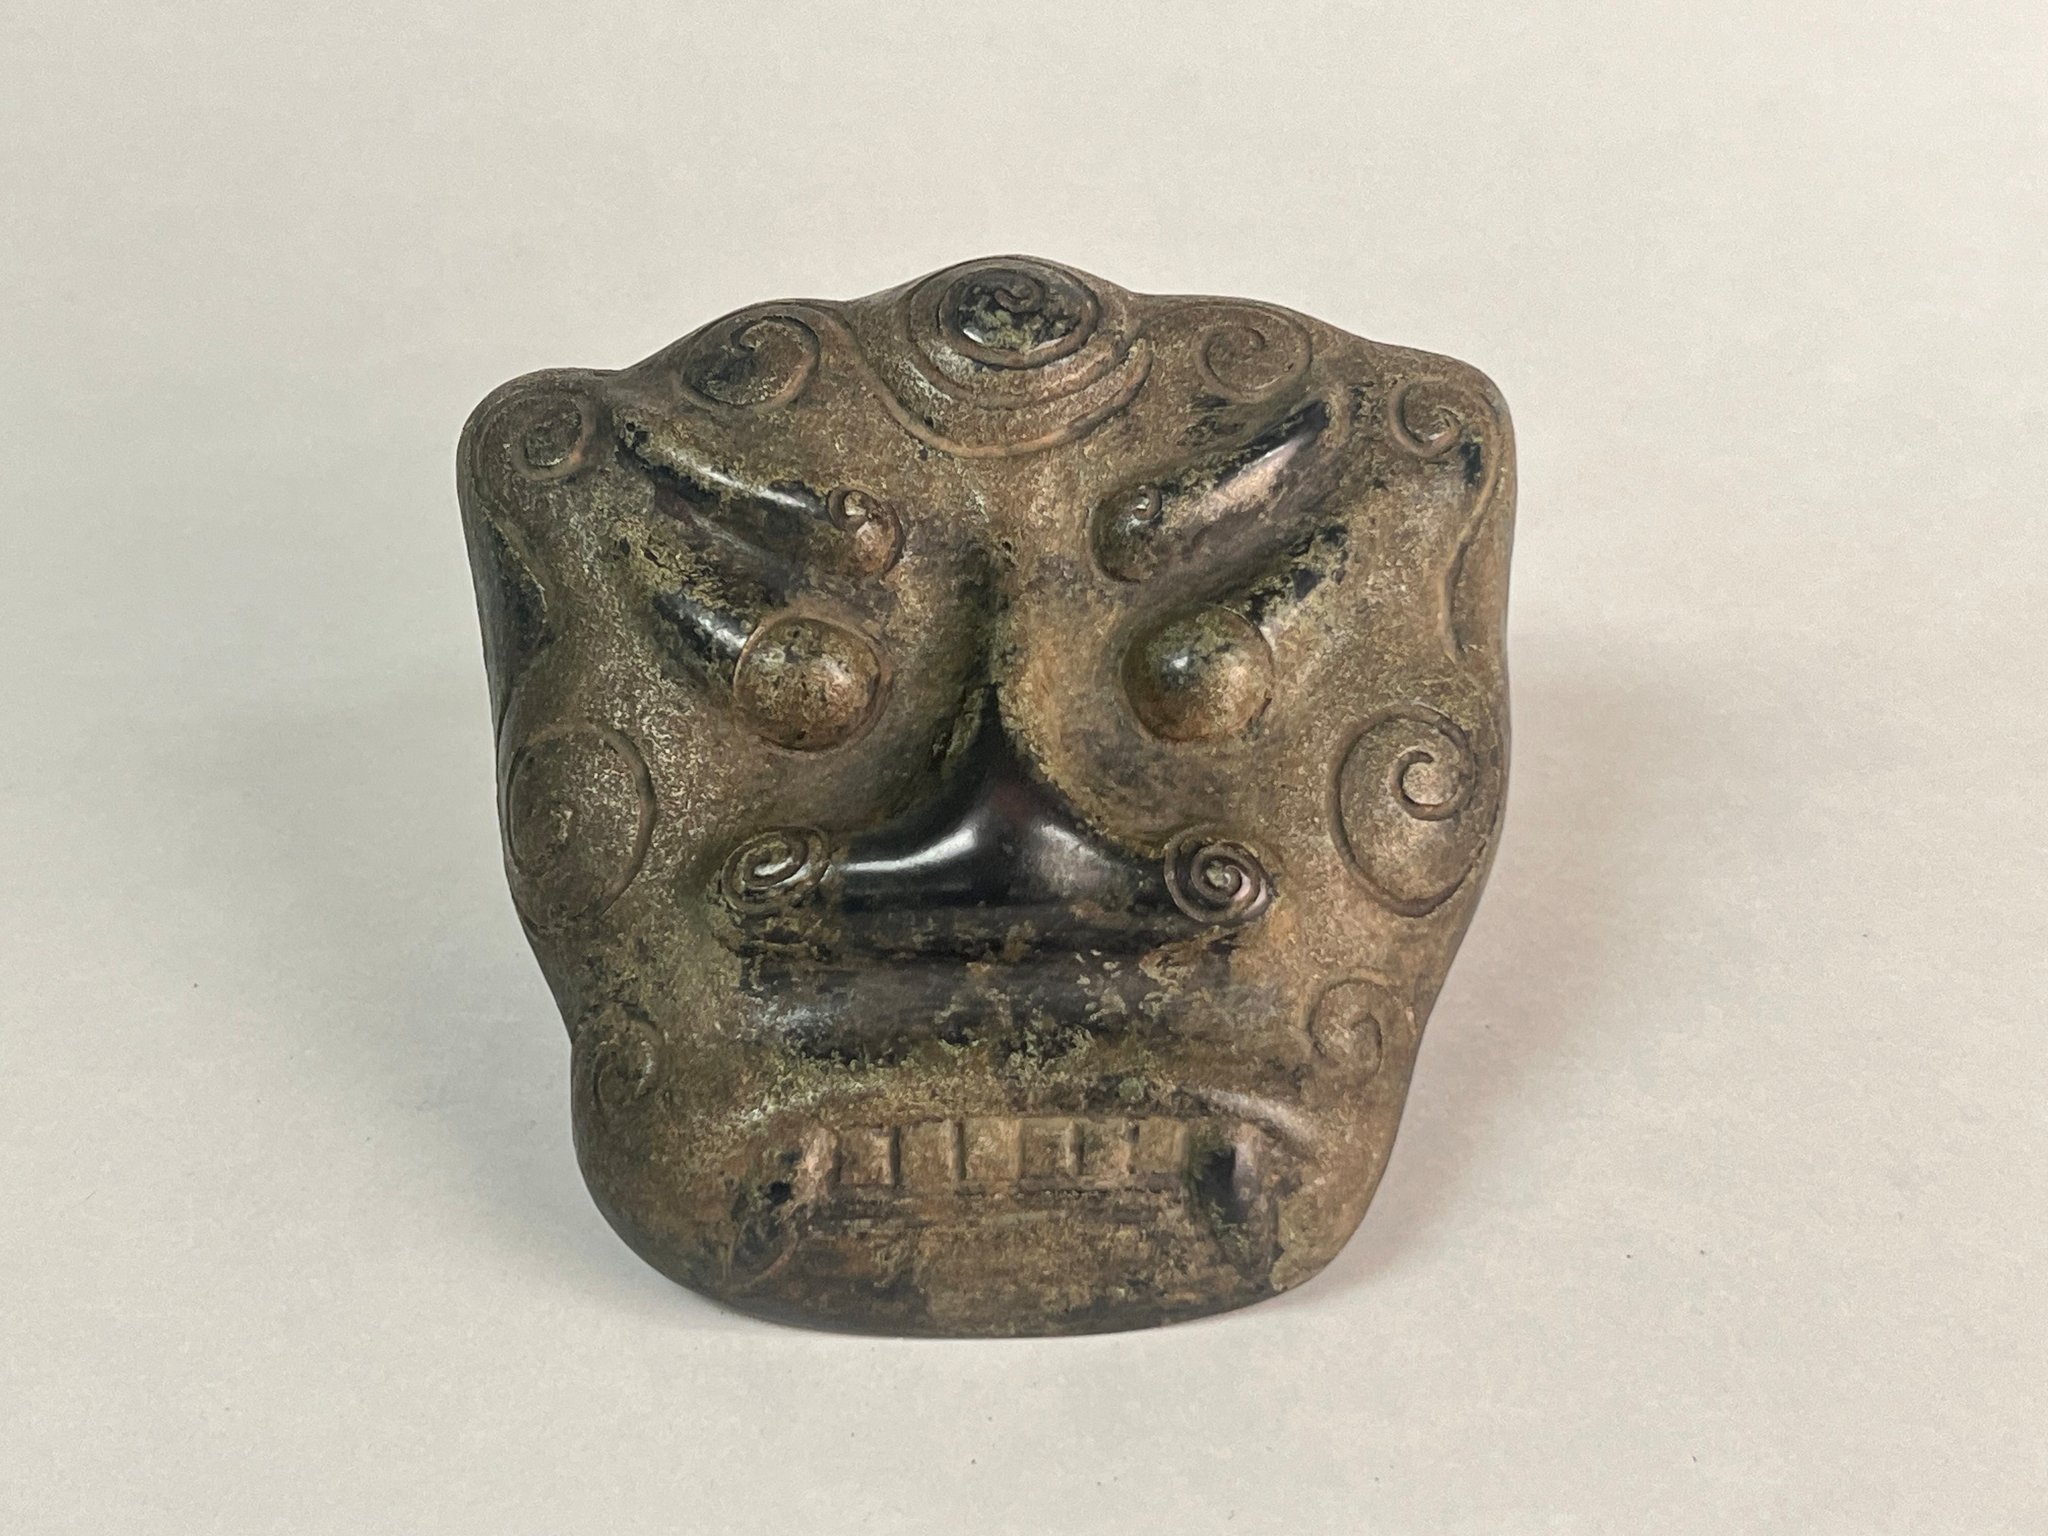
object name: mask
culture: chinese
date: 1046-256 BCE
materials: bronze